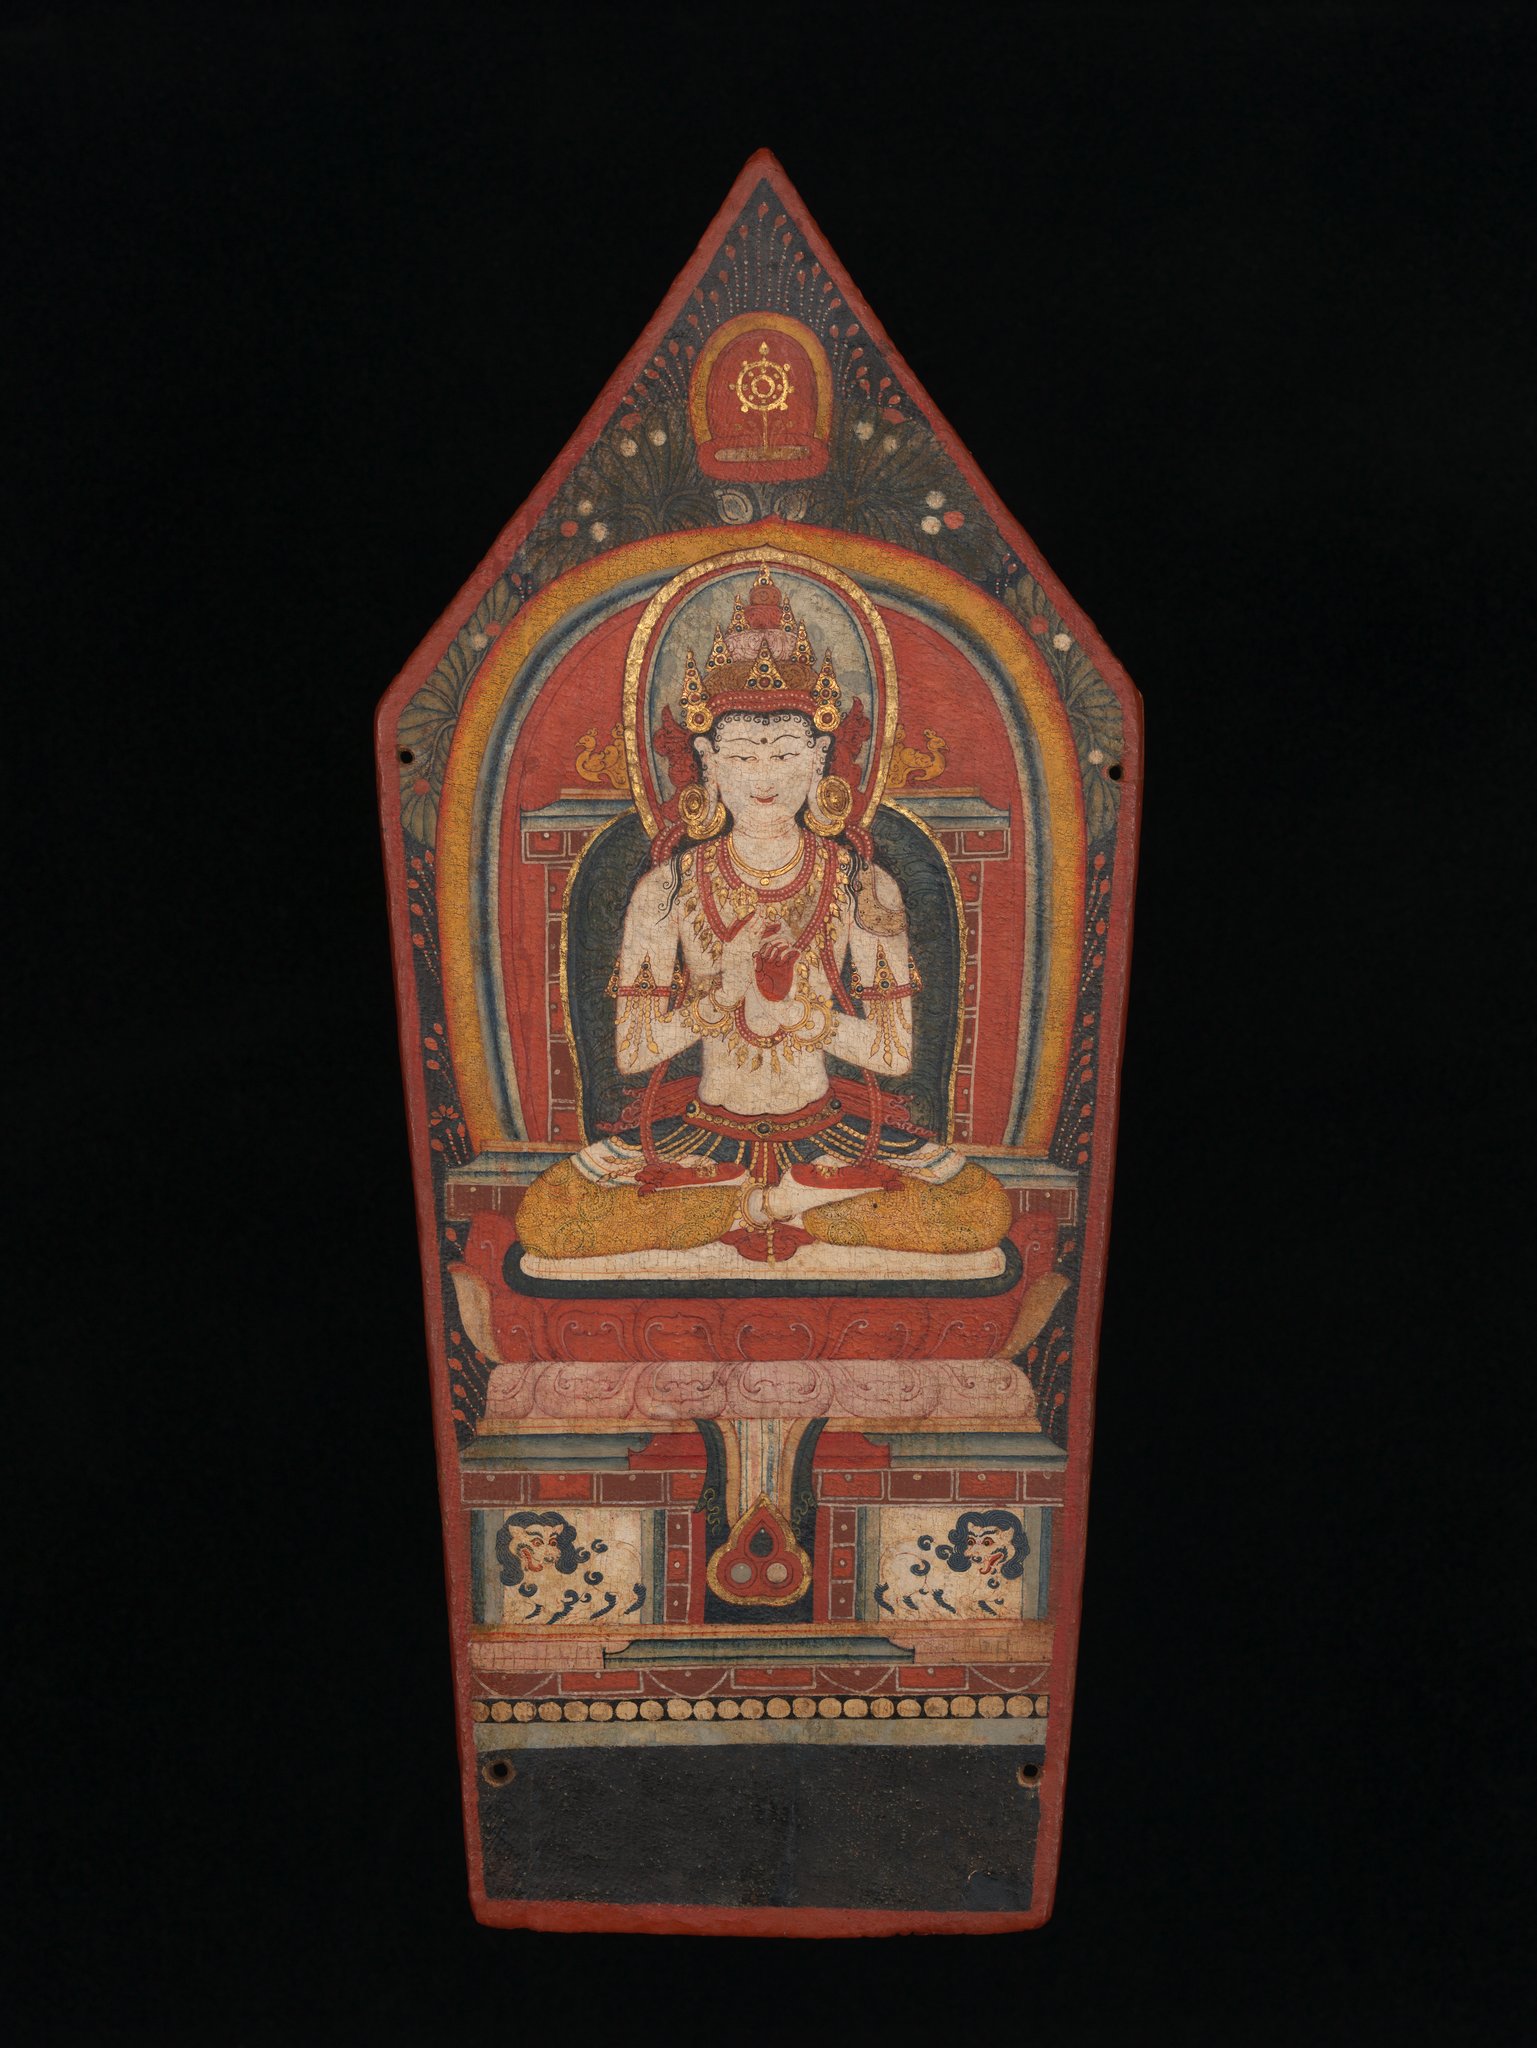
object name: crown panel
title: Panel from a Buddhist Ritual Crown Depicting Vairocana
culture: tibetan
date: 1267-1333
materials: wood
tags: buddhism,buddha